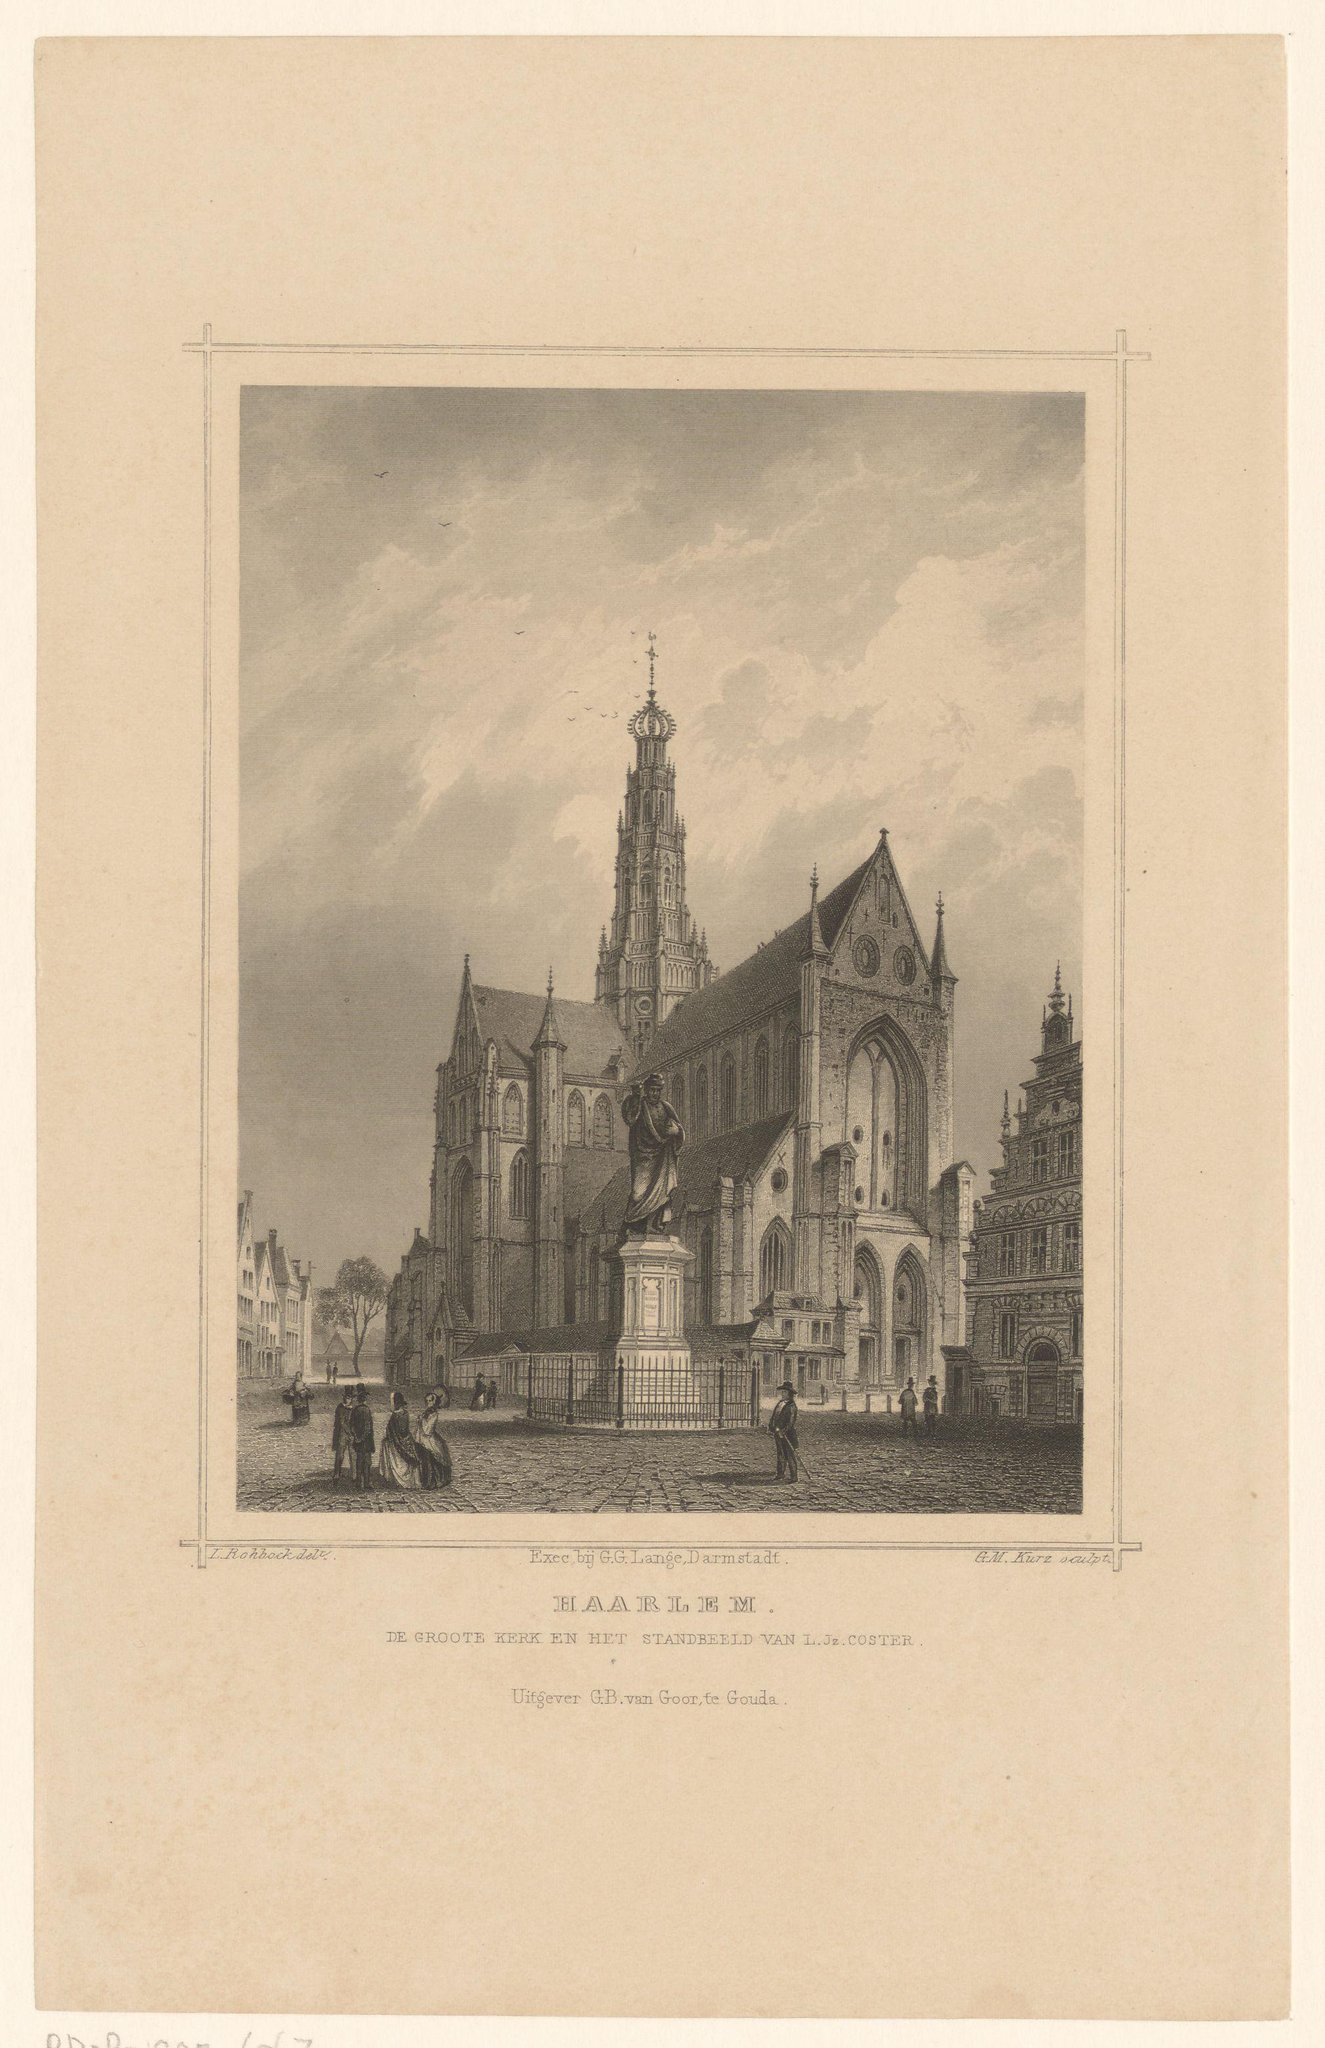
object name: print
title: Haarlem. De groote kerk en het standbeeld van L. Jz. Coster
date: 1839-1871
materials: paper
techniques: engraving, etching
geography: darmstadt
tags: square, place, circus, etc., parts of church exterior and annexes: façade, sculpture, city-view, and landscape with man-made constructions (+ city(-scape) with figures, staffage)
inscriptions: collector's mark: Lugt 2228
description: Deze prent hoort bij een serie van 24 Nederlandse stadsgezichten.